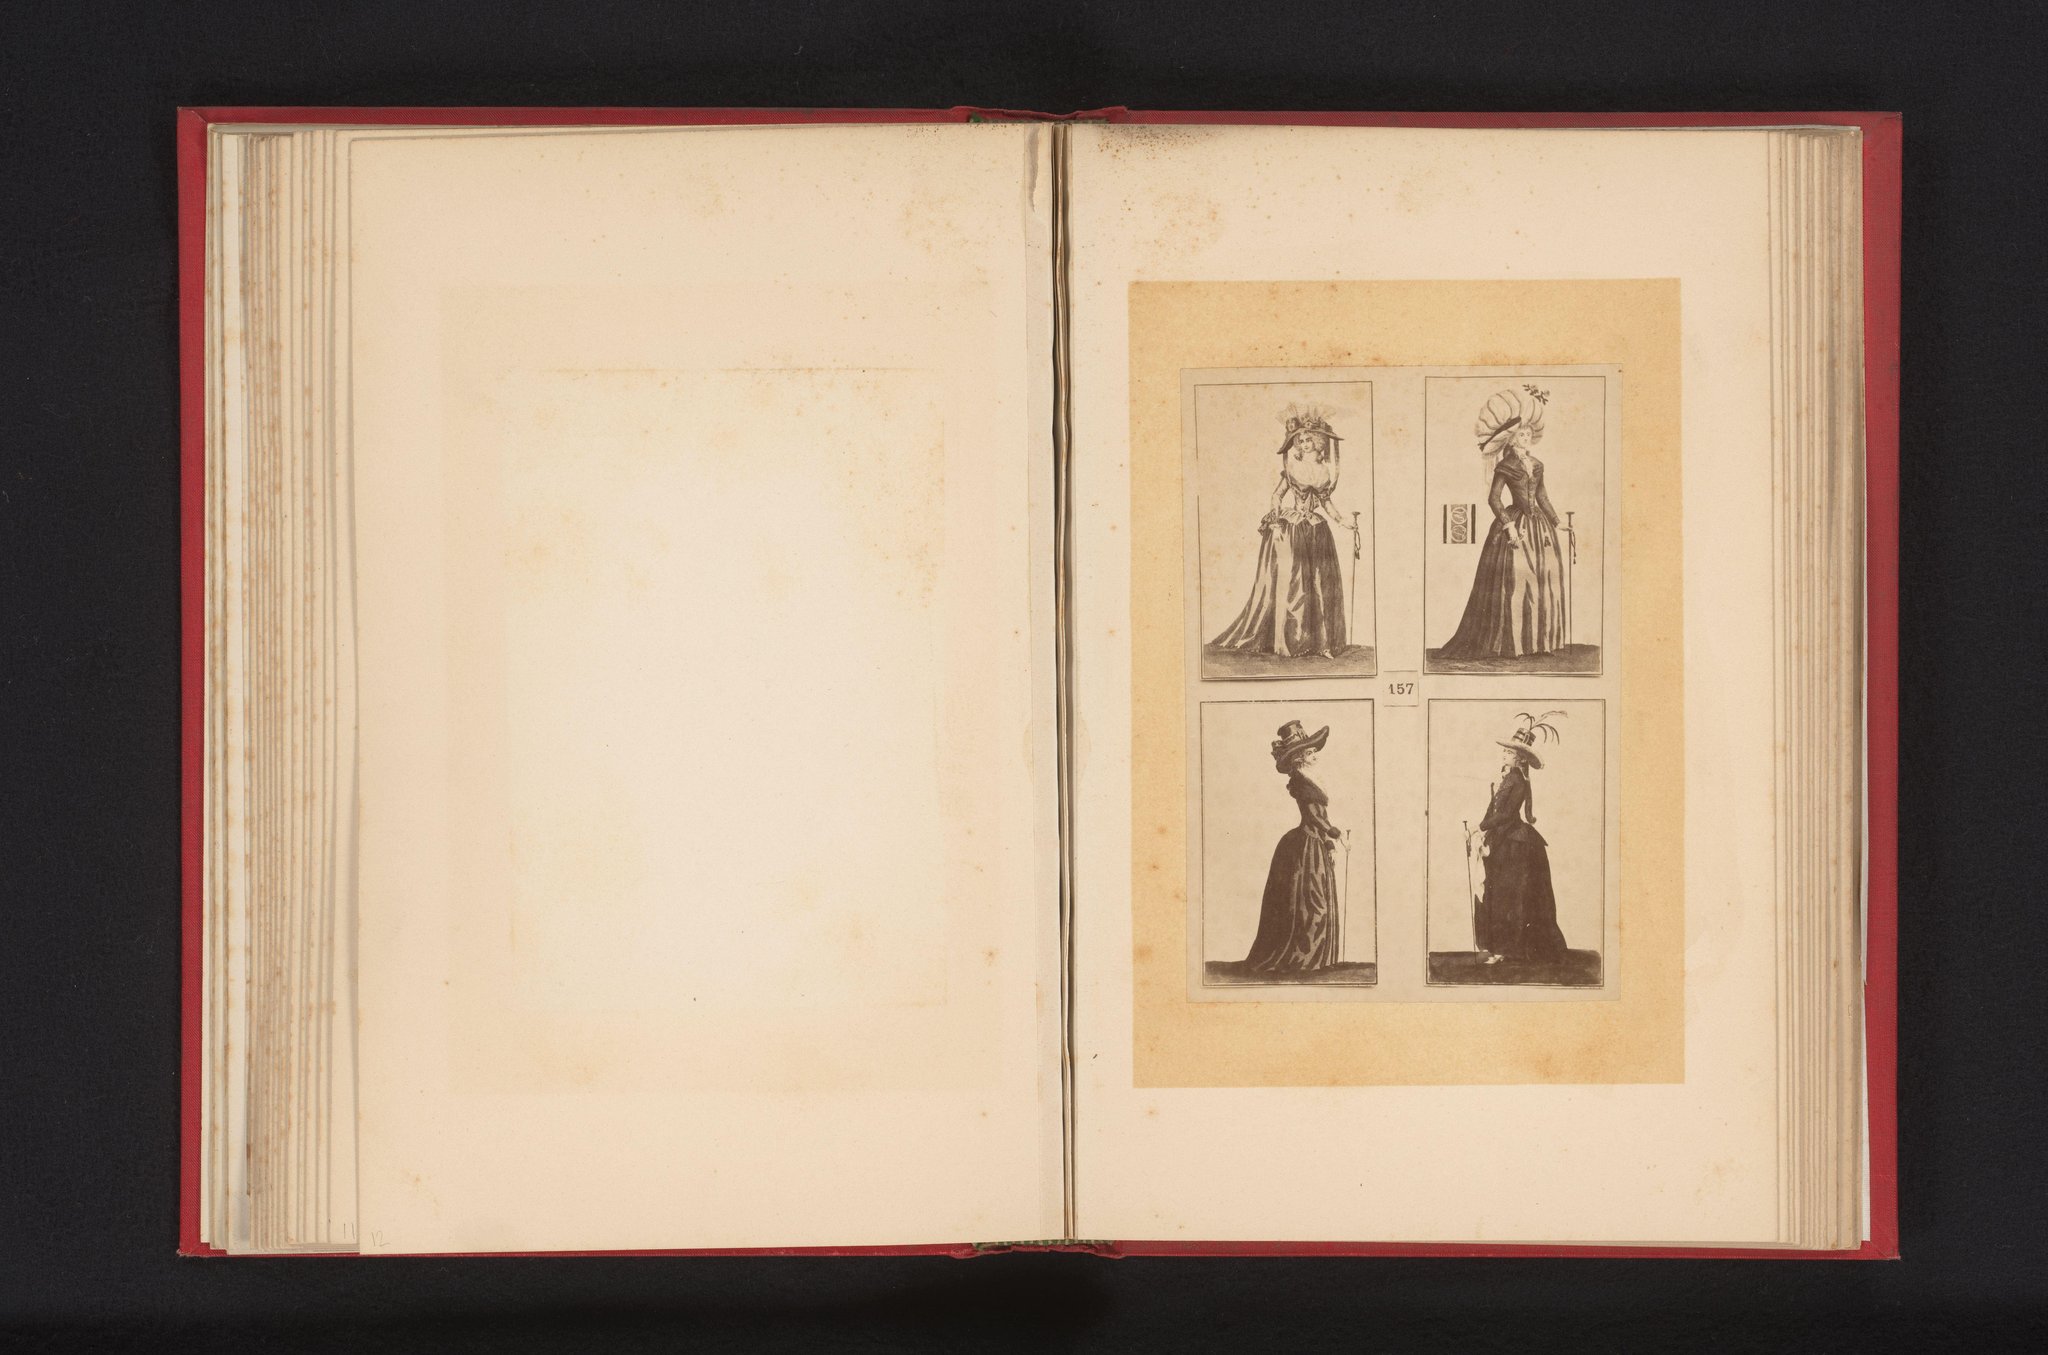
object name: photograph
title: Vier figuren in klederdracht uit 1787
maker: Anonymous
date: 1873-1878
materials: photographic support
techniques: albumen print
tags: folk costume, regional costume, painting, drawing and the graphic arts